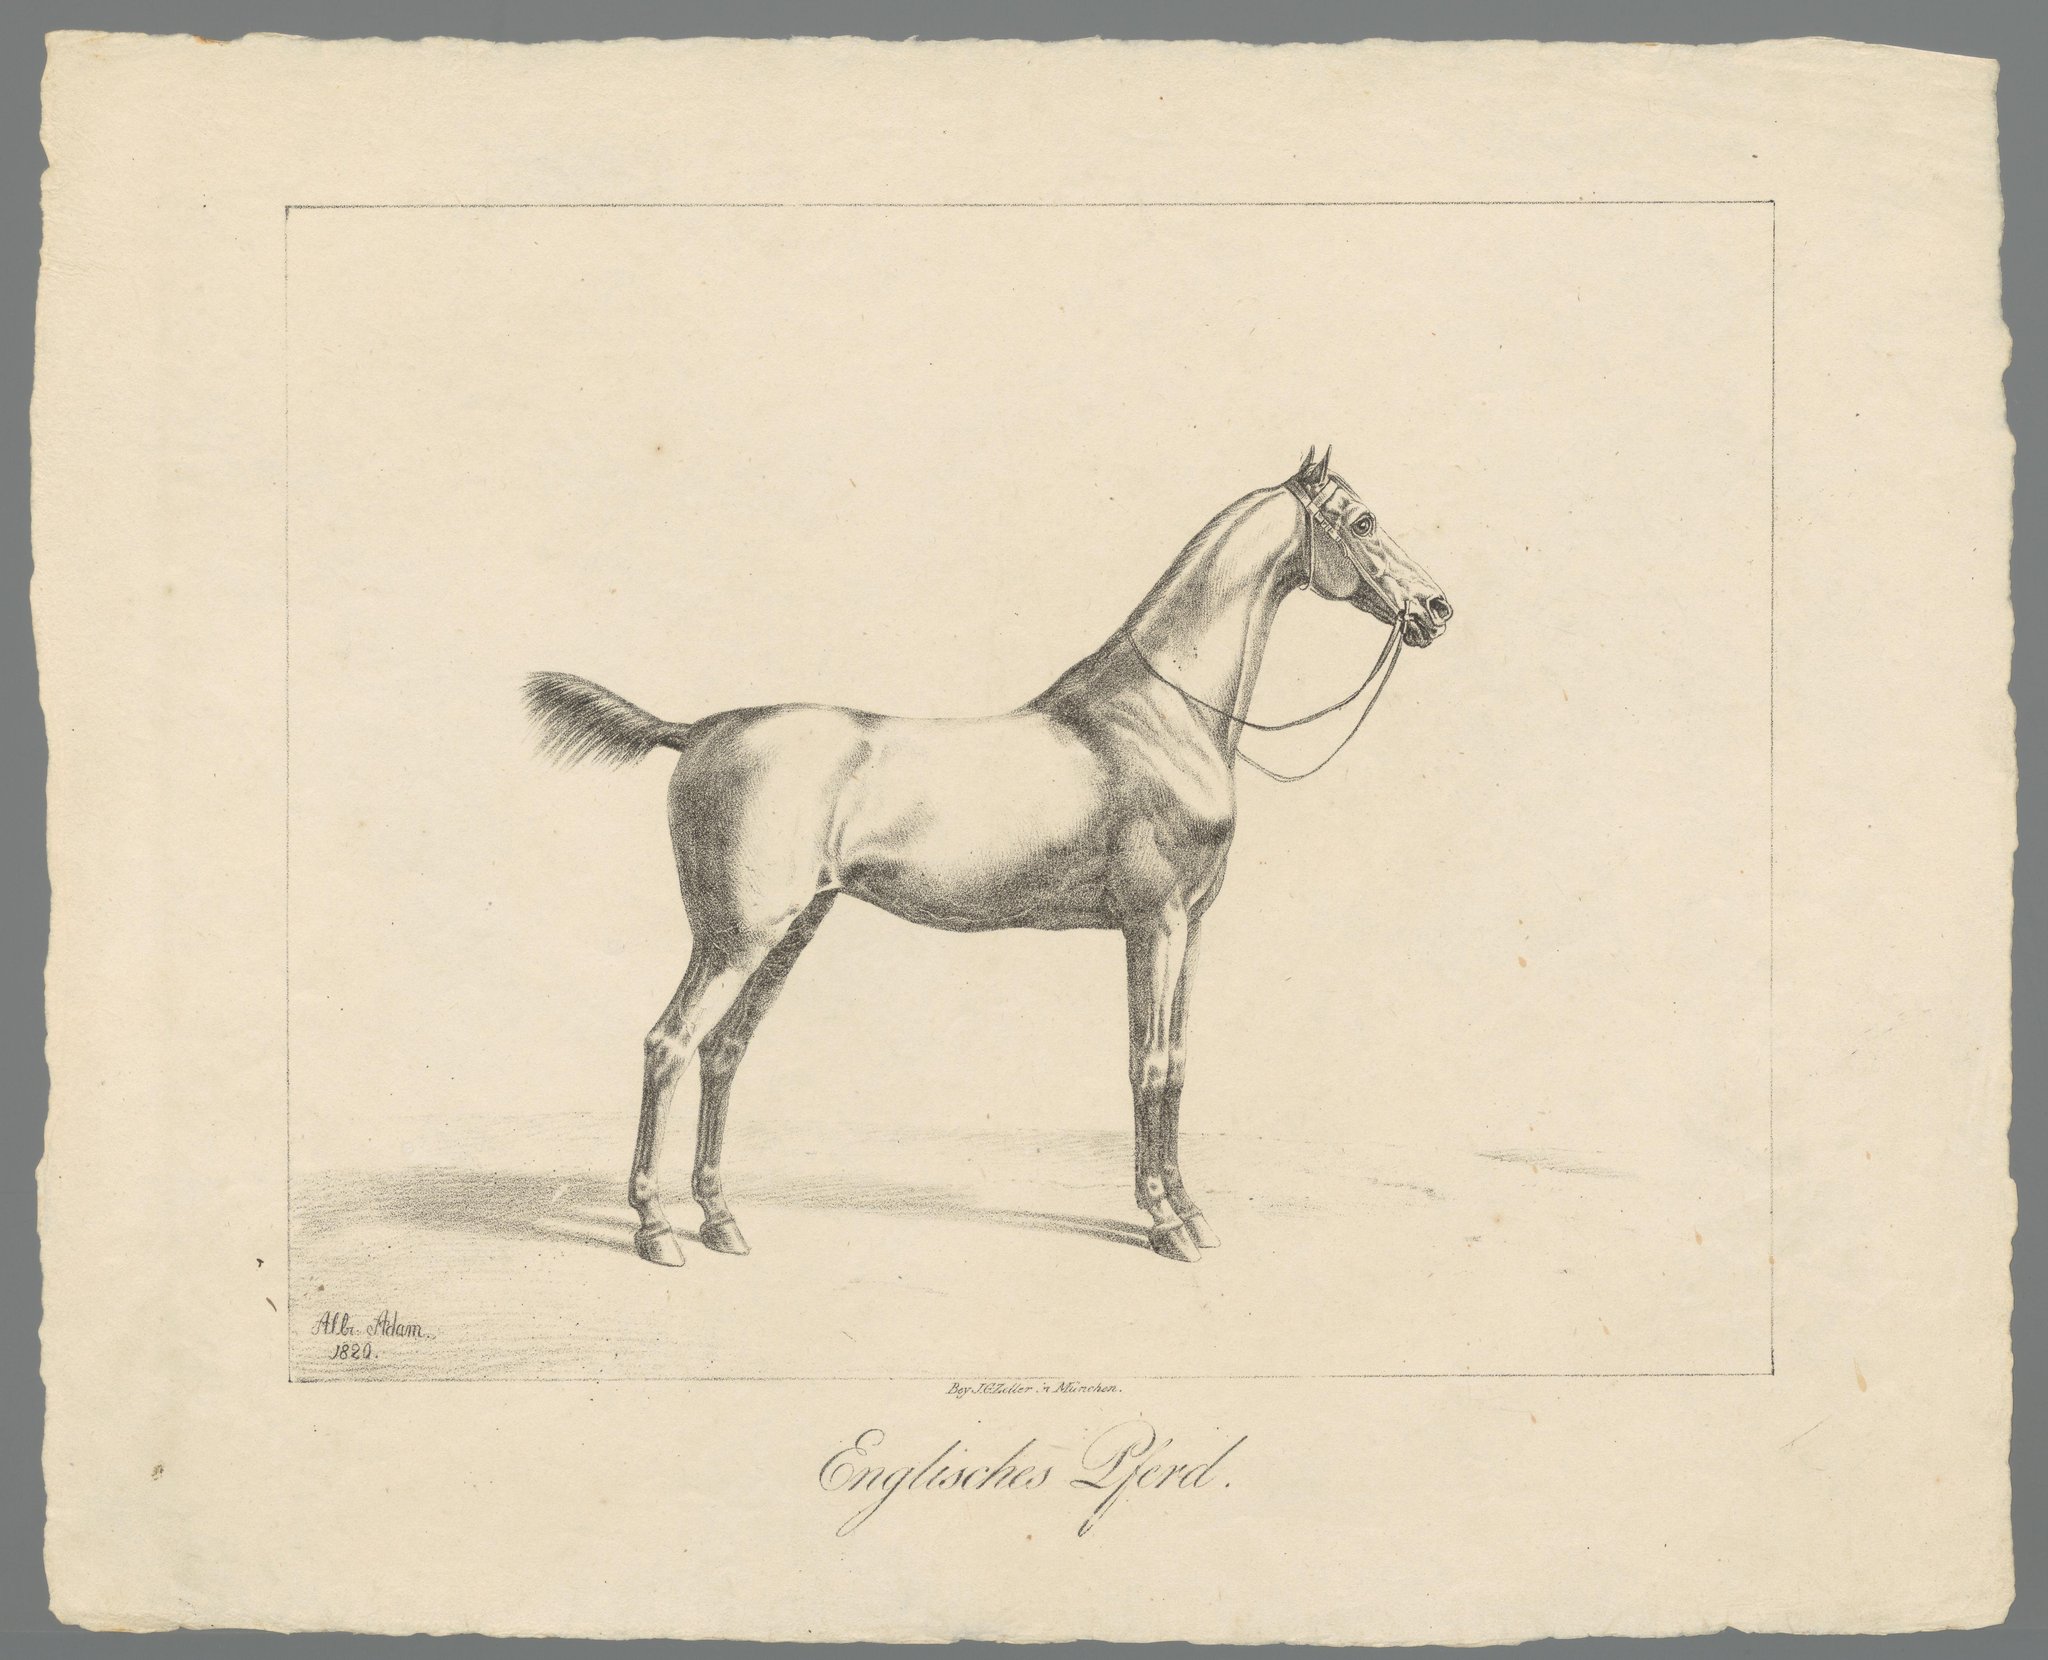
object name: print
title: Thier-Studien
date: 1820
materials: paper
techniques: lithograph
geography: munich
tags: horse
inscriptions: collector's mark: Lugt 2228